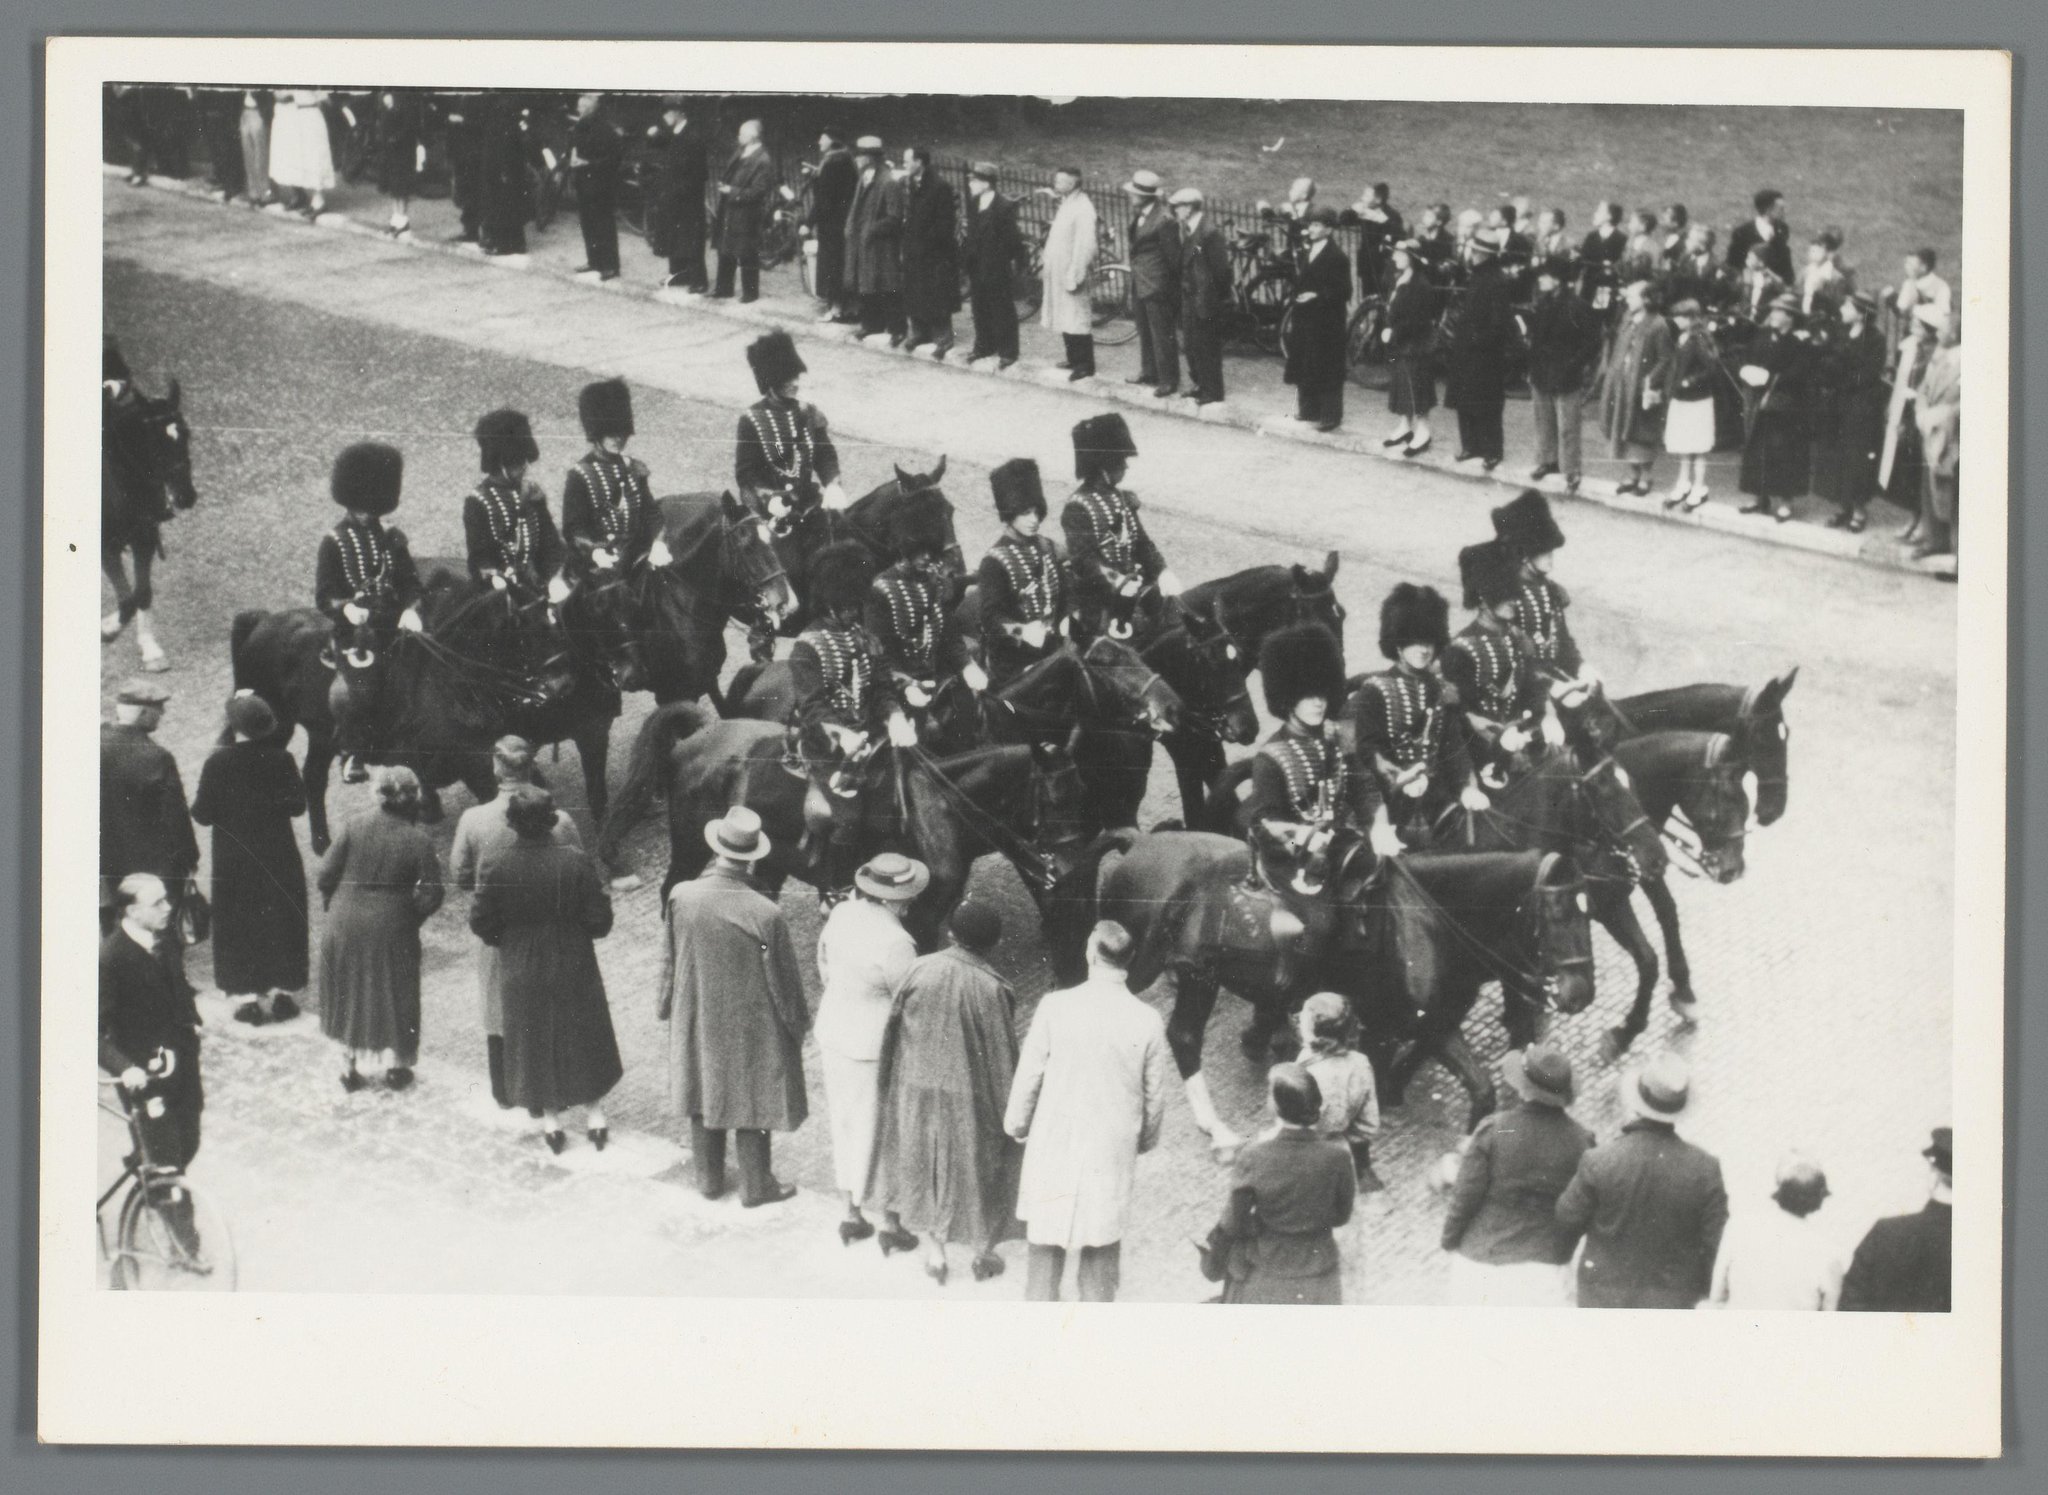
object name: photograph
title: Korps Rijdende Artillerie tijdens een parade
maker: Anonymous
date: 1935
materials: paper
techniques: gelatin silver print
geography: netherlands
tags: riding a horse, ass, or mule; rider, horseman, the company, the unit, the troop ~ military service, military parade, pageant, netherlands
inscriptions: number: ‘11’